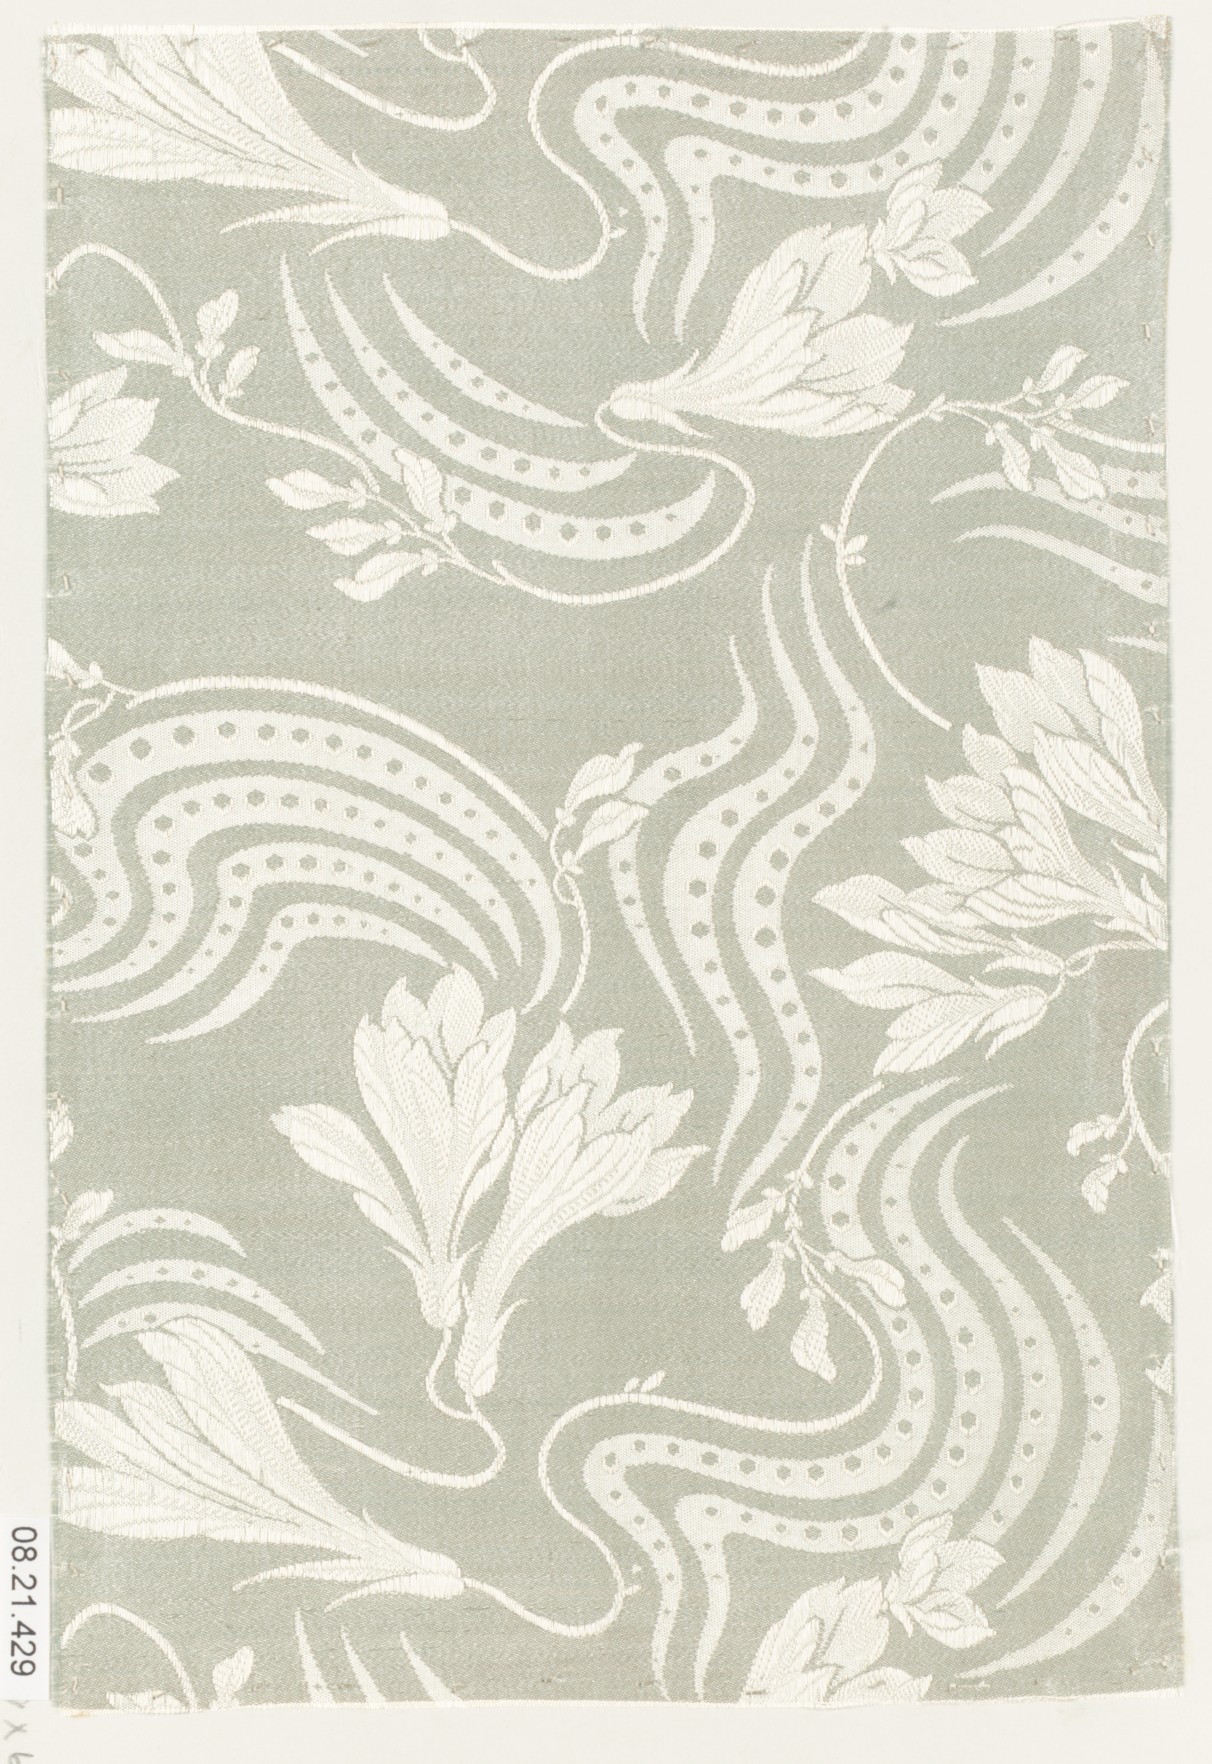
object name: textile sample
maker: Anonymous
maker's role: designer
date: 1900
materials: silk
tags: flowers